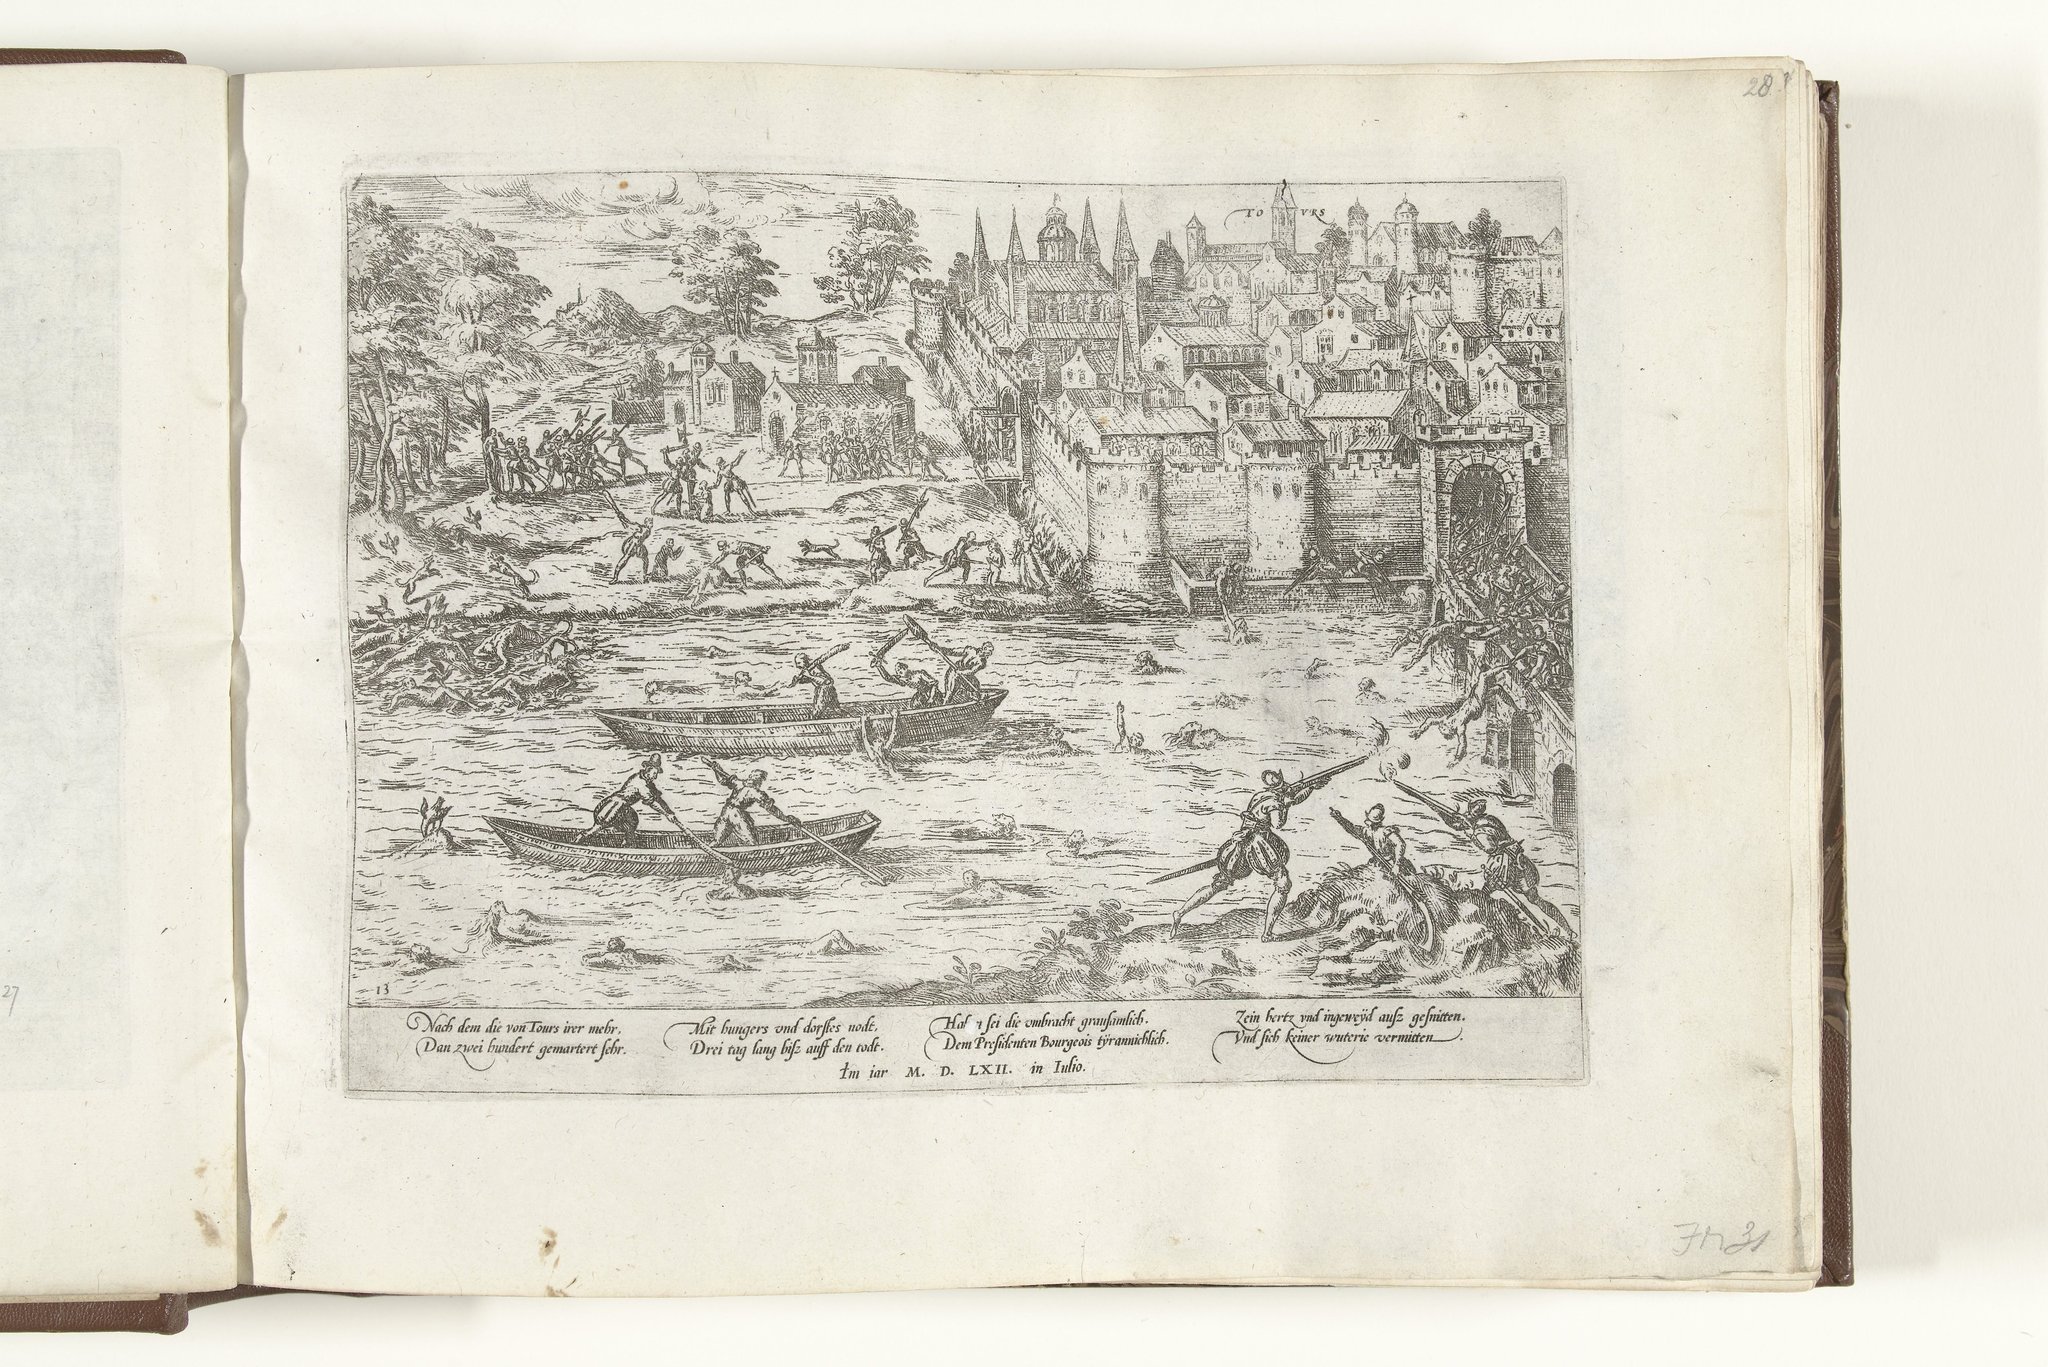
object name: album leaf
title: Moord op de protestanten in Tours, 1562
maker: frans hogenberg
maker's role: print maker, publisher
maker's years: 1538-1590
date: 1565-1573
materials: paper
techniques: etching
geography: cologne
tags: massacre ~ war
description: Gekopieerd naar de prent in: Jean Tortorel et Jacques Perrissin, Premier volume contenant quarante tableaux ou Histoires diverses qui sont memorables touchant les Guerres, Massacres et Troubles advenus en France en ces dernieres annees : le tout recueilly selon le tesmoignange de ceux qui y ont esté en personne et qui les ont veus : lesquels sont pourtraits à la vérité, Genève ca. 1570. Bibliotheek Rijksmuseum: 329 A 2, pl. 14.